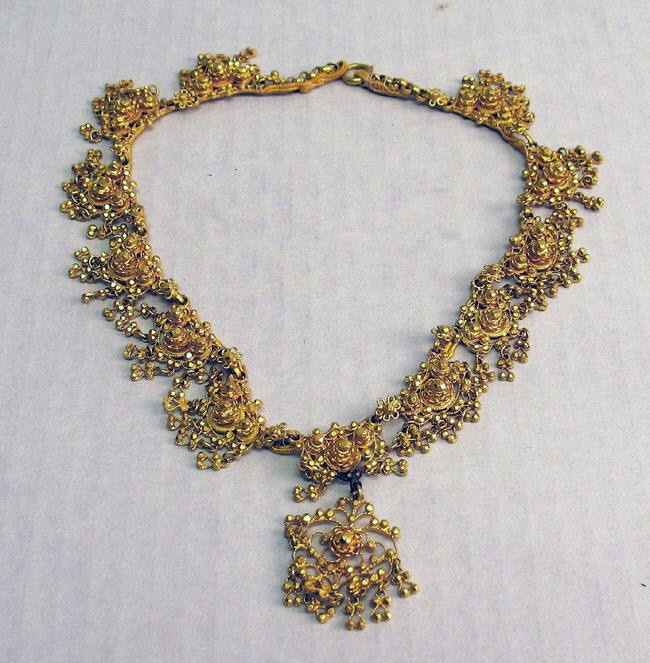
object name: necklace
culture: indian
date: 1801-1900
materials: gold